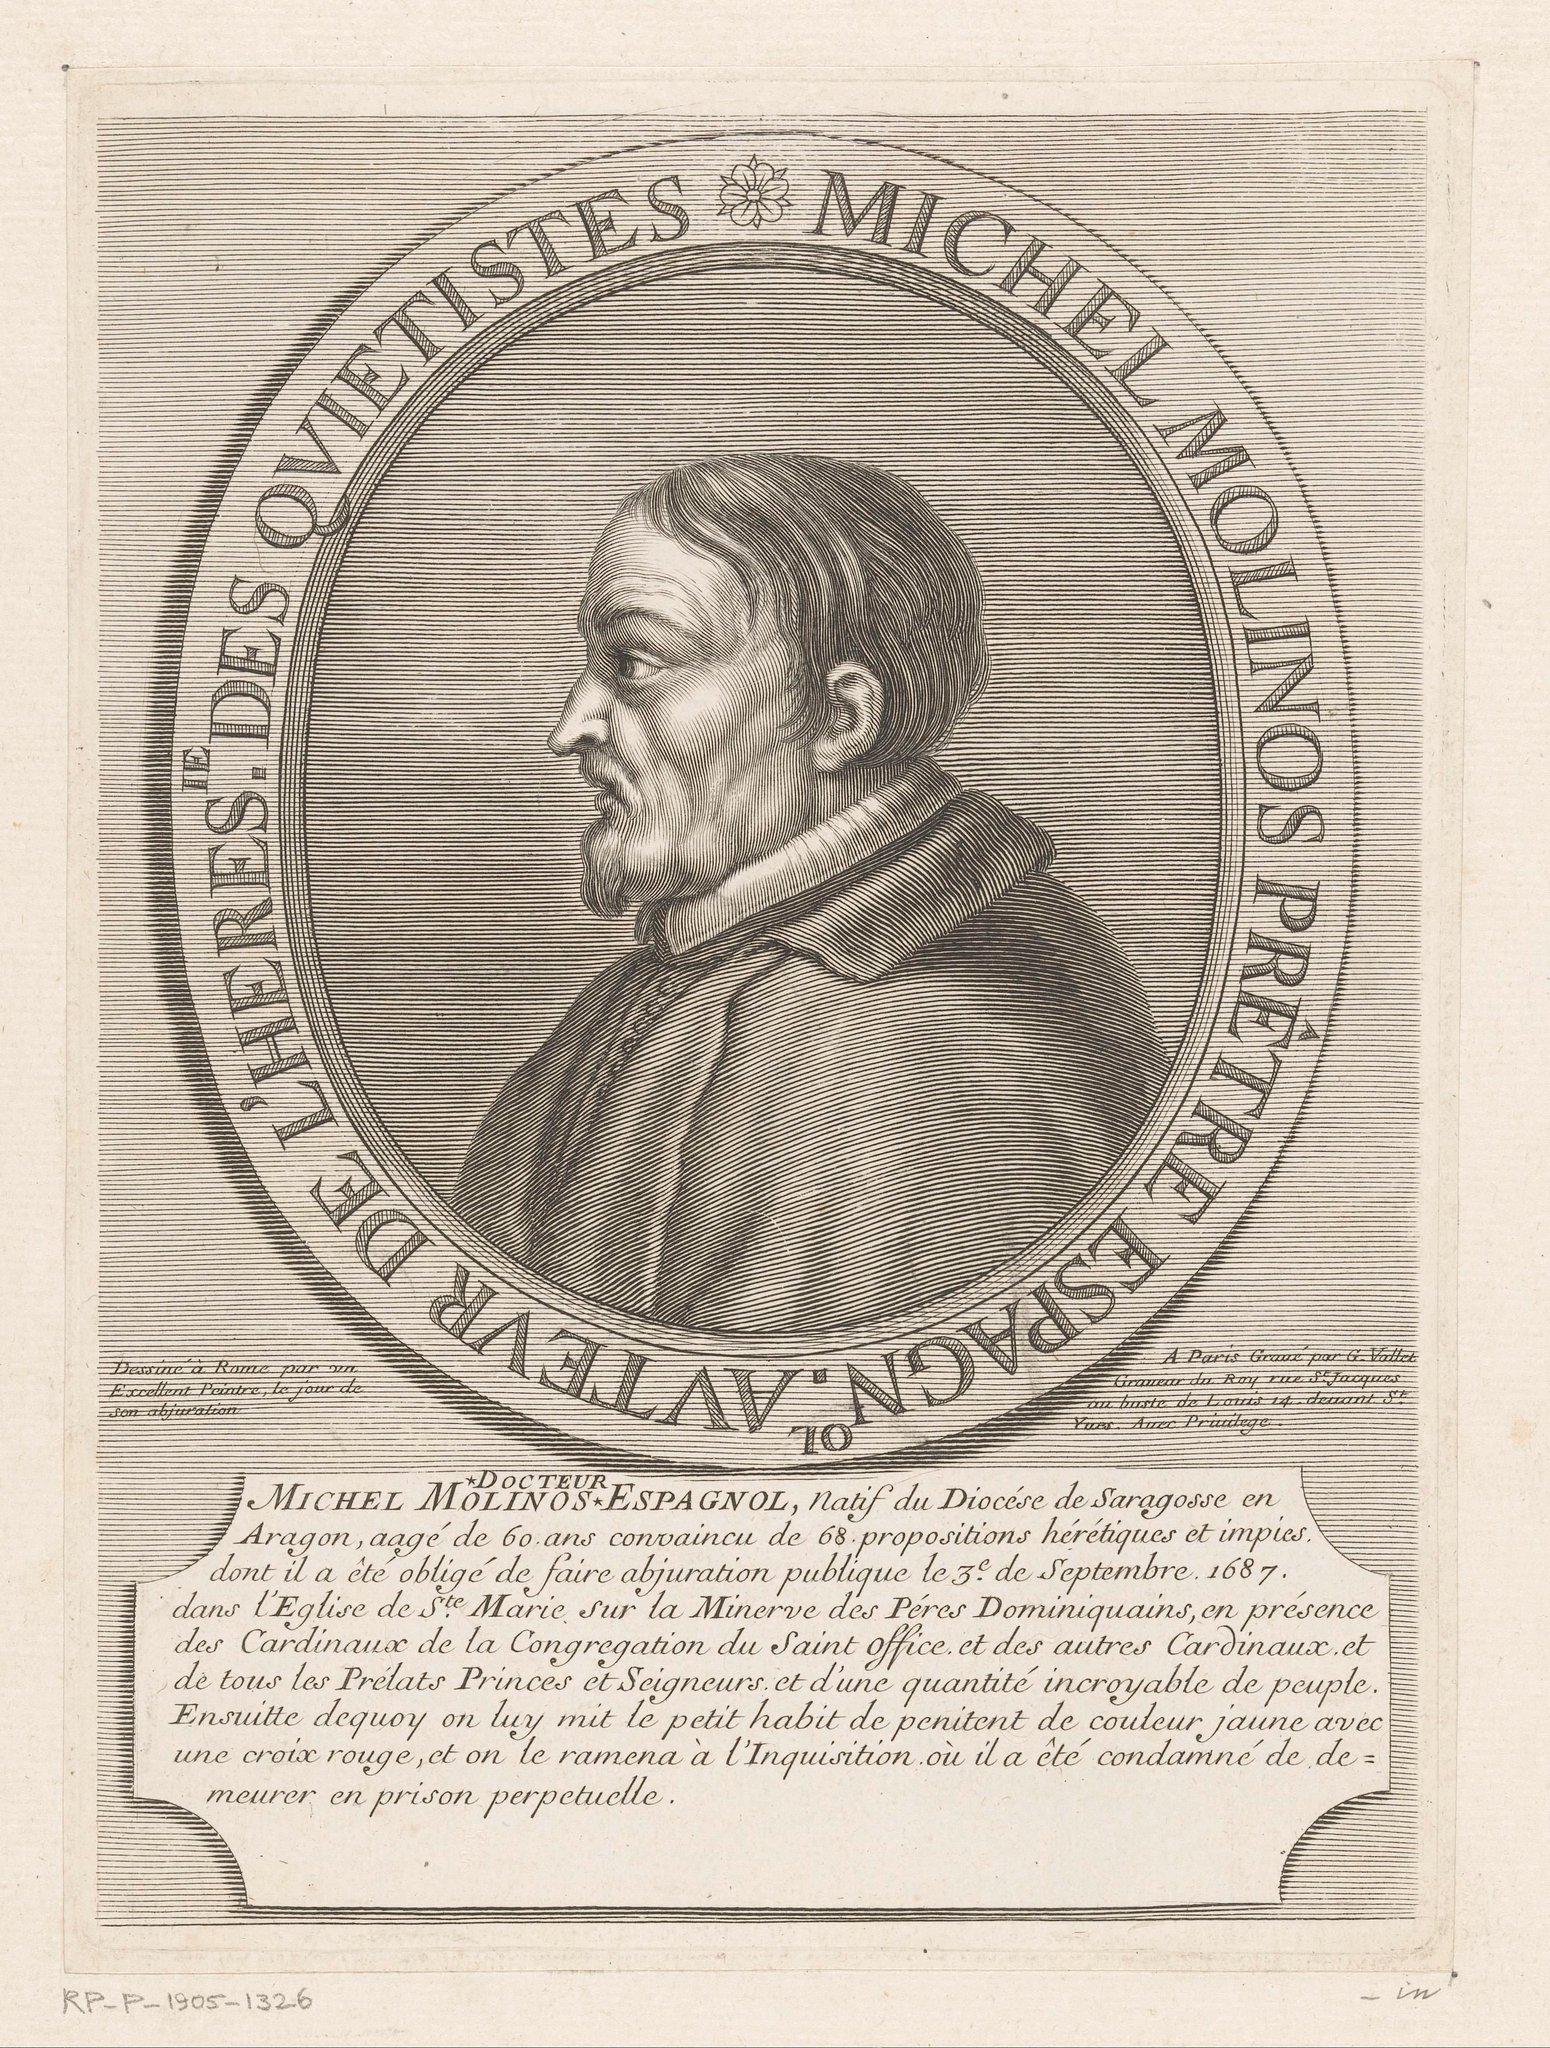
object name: print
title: Portret van Miguel de Molinos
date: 1661-1704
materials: paper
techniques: engraving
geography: paris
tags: rome, historical persons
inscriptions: collector's mark: Lugt 2228